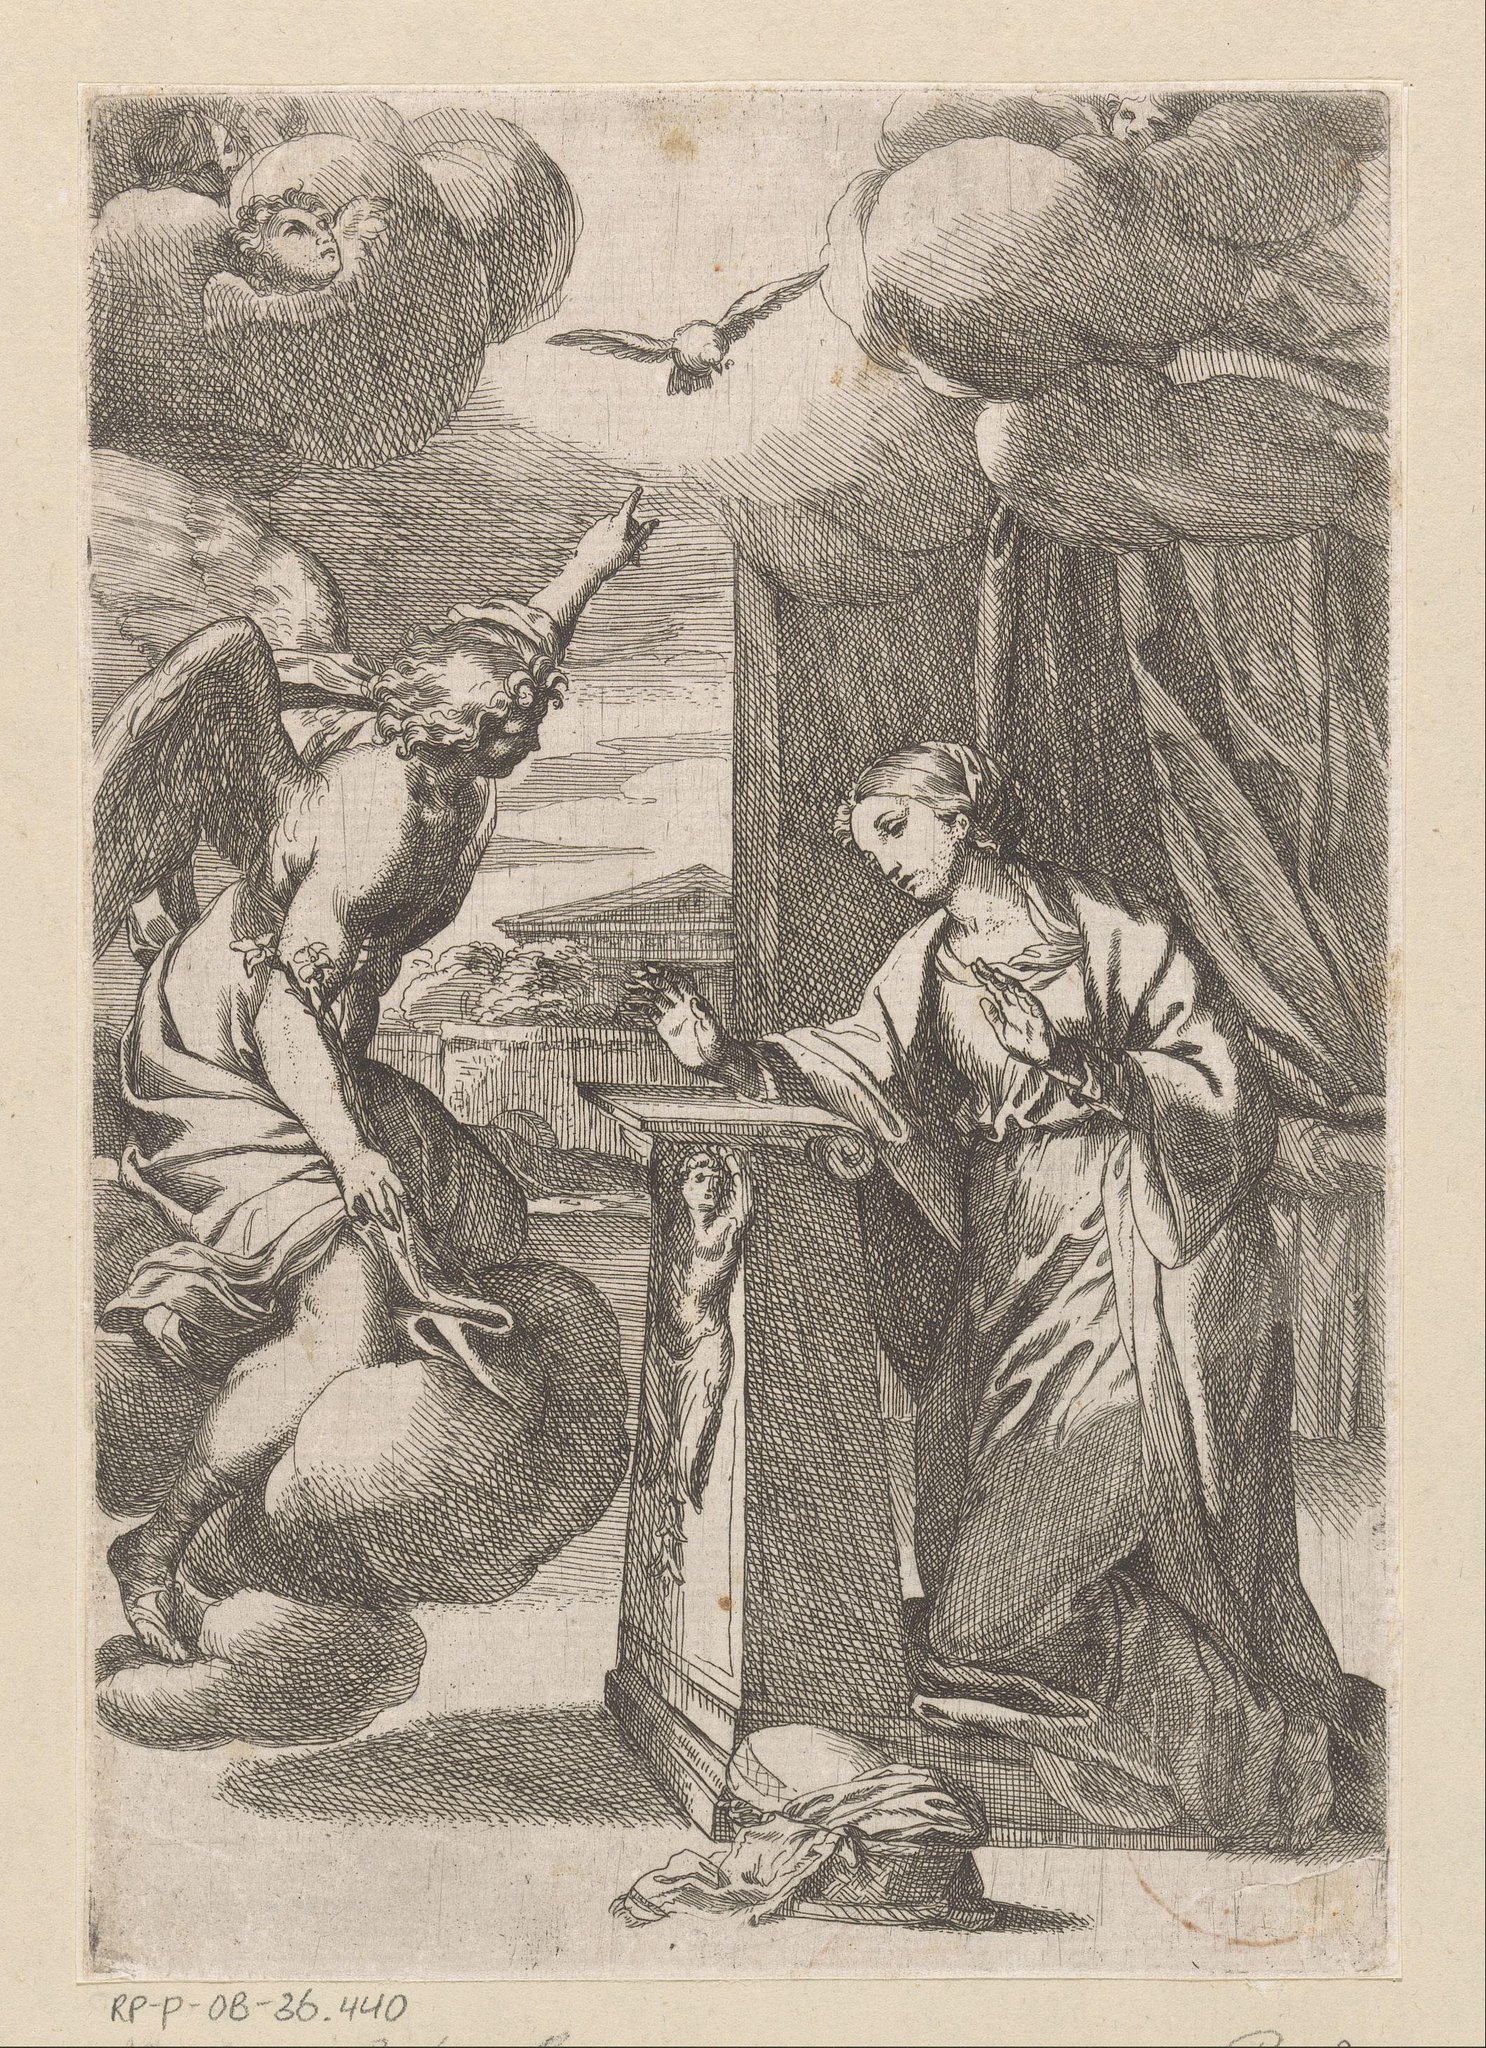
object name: print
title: Annunciatie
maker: carlo maratta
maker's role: draughtsman, painter, print maker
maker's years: 1625-1713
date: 1635-1713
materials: paper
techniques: etching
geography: rome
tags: the annunciation: mary, usually reading, is visited by the angel (sometimes a woman overhears the conversation)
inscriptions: collector's mark: Lugt 240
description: De engel Gabriël kondigt aan Maria aan dat ze zwanger zal worden. Maria zit geknield bij een lezenaar. De Heilige Geest daalt als een duif neer. Boven zweven cherubijnen tussen wolken.